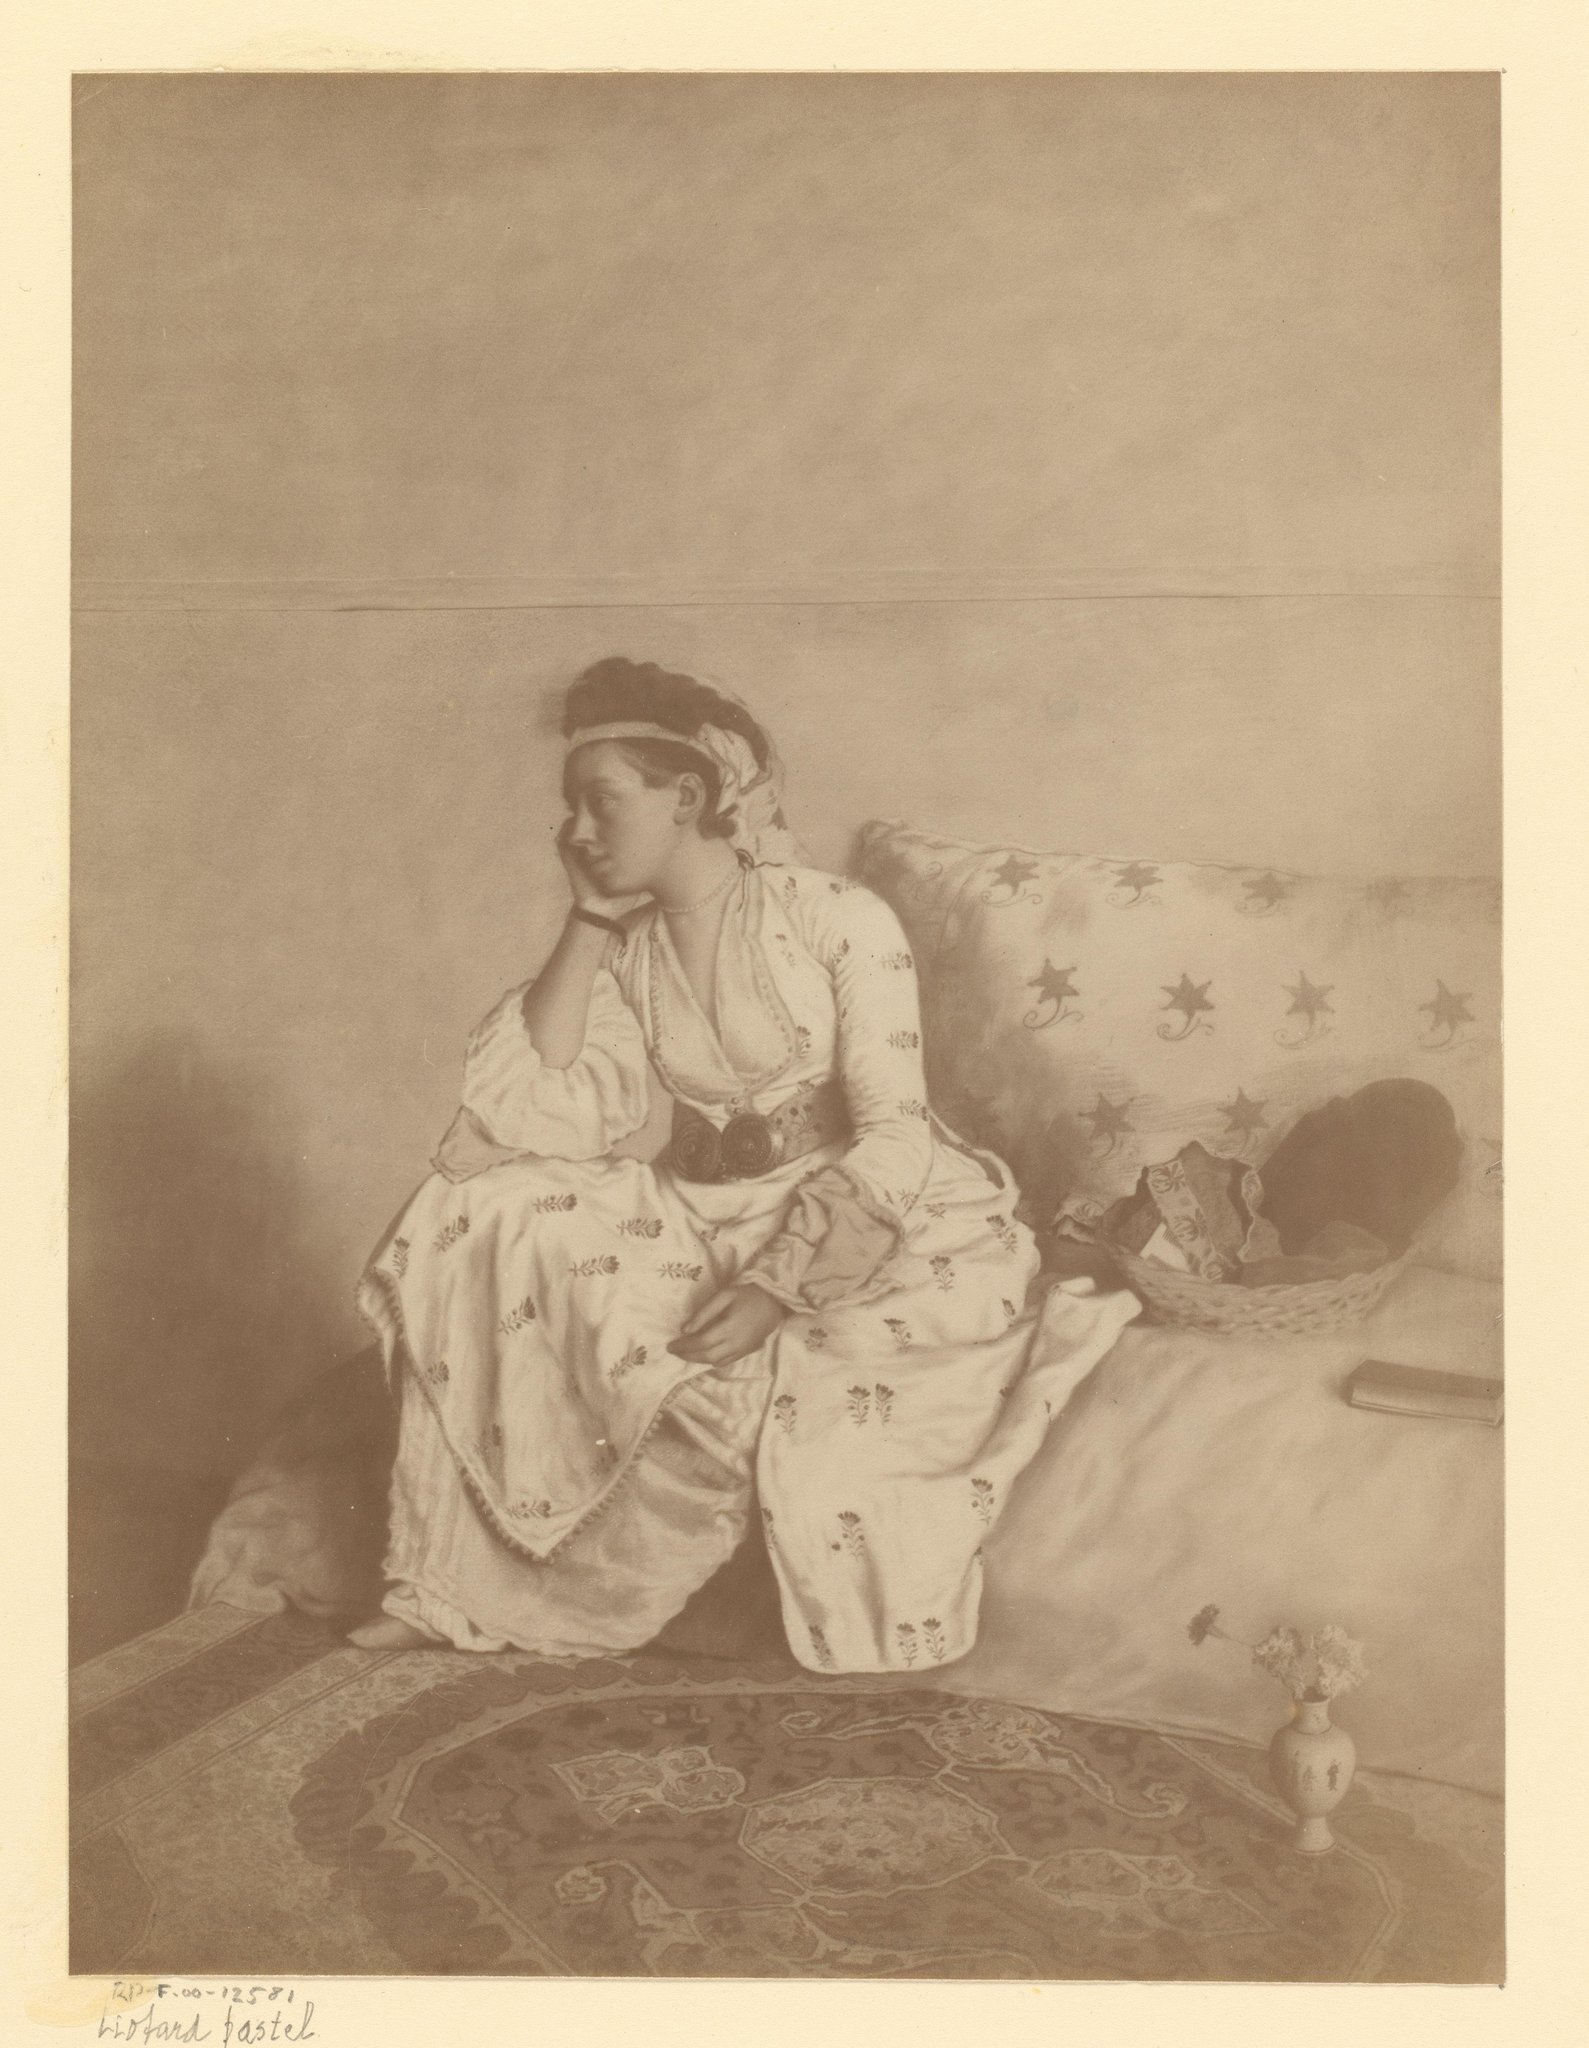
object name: reproduction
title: Fotoreproductie van een getekend portret van Marie Fargues in Turks kostuum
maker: Anonymous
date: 1873-1900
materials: paper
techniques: albumen print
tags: historical persons - bb - woman, folk costume, regional costume